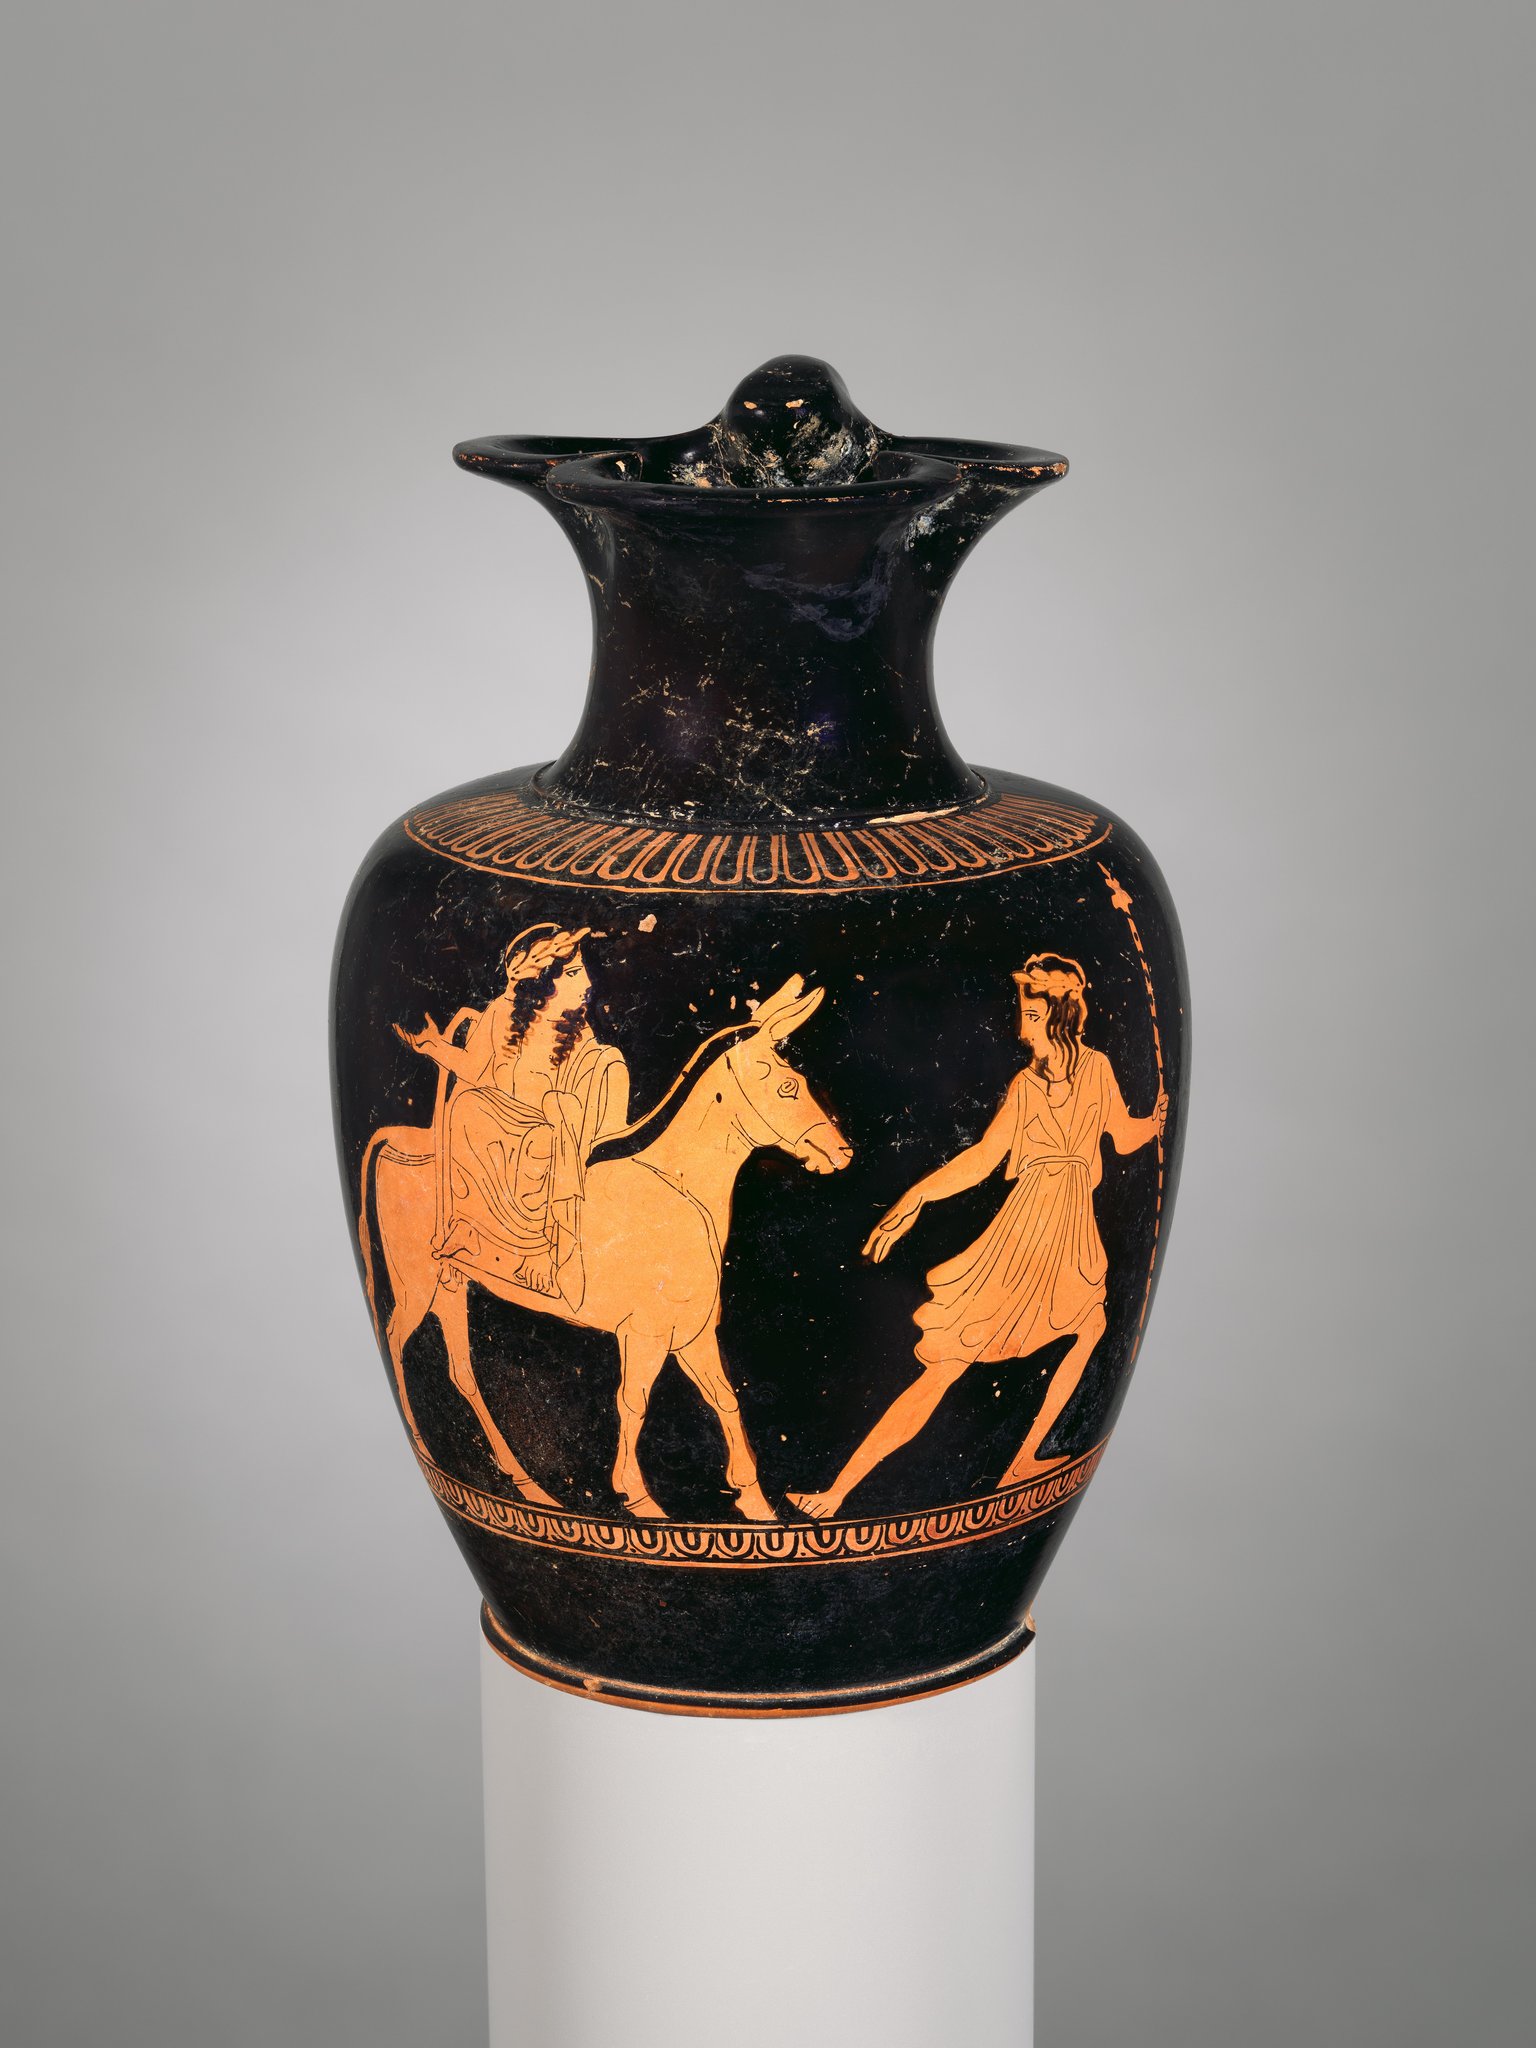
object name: oinochoe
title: Terracotta oinochoe (jug)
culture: greek, attic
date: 430 BCE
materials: terracotta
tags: animals,boys